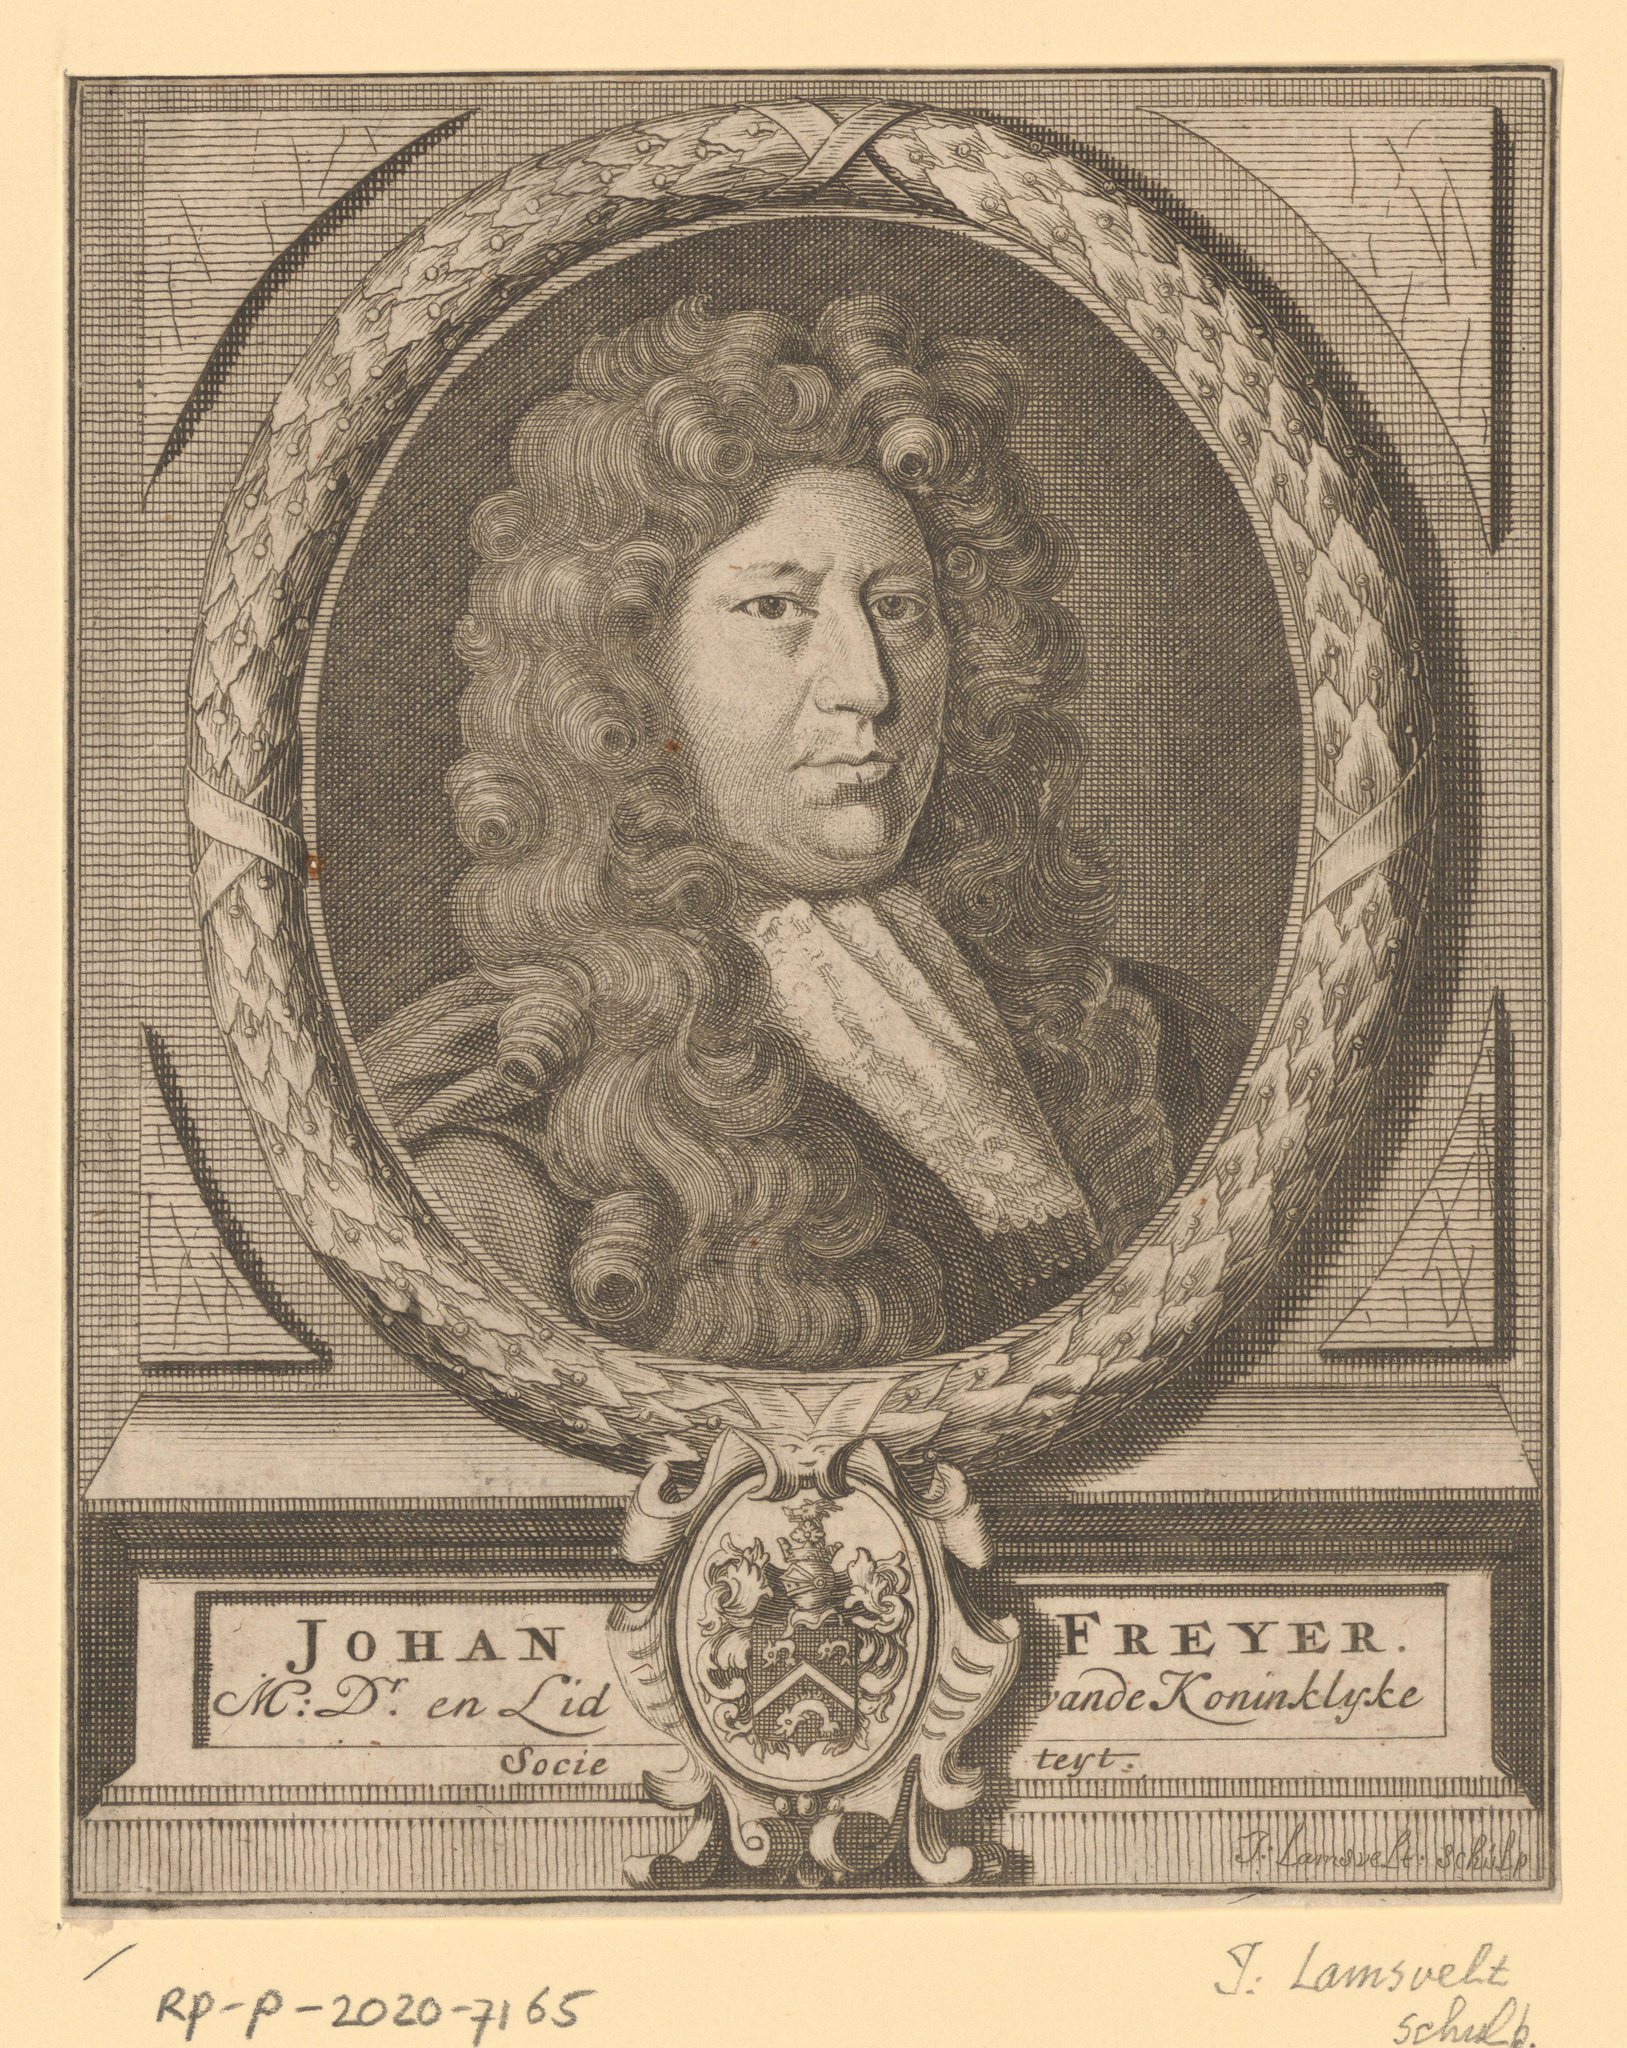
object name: print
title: Portret van Johan Freyer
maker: jan lamsvelt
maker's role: print maker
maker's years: 1674-1743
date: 1696-1743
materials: paper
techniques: etching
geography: amsterdam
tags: historical persons, armorial bearing, heraldry